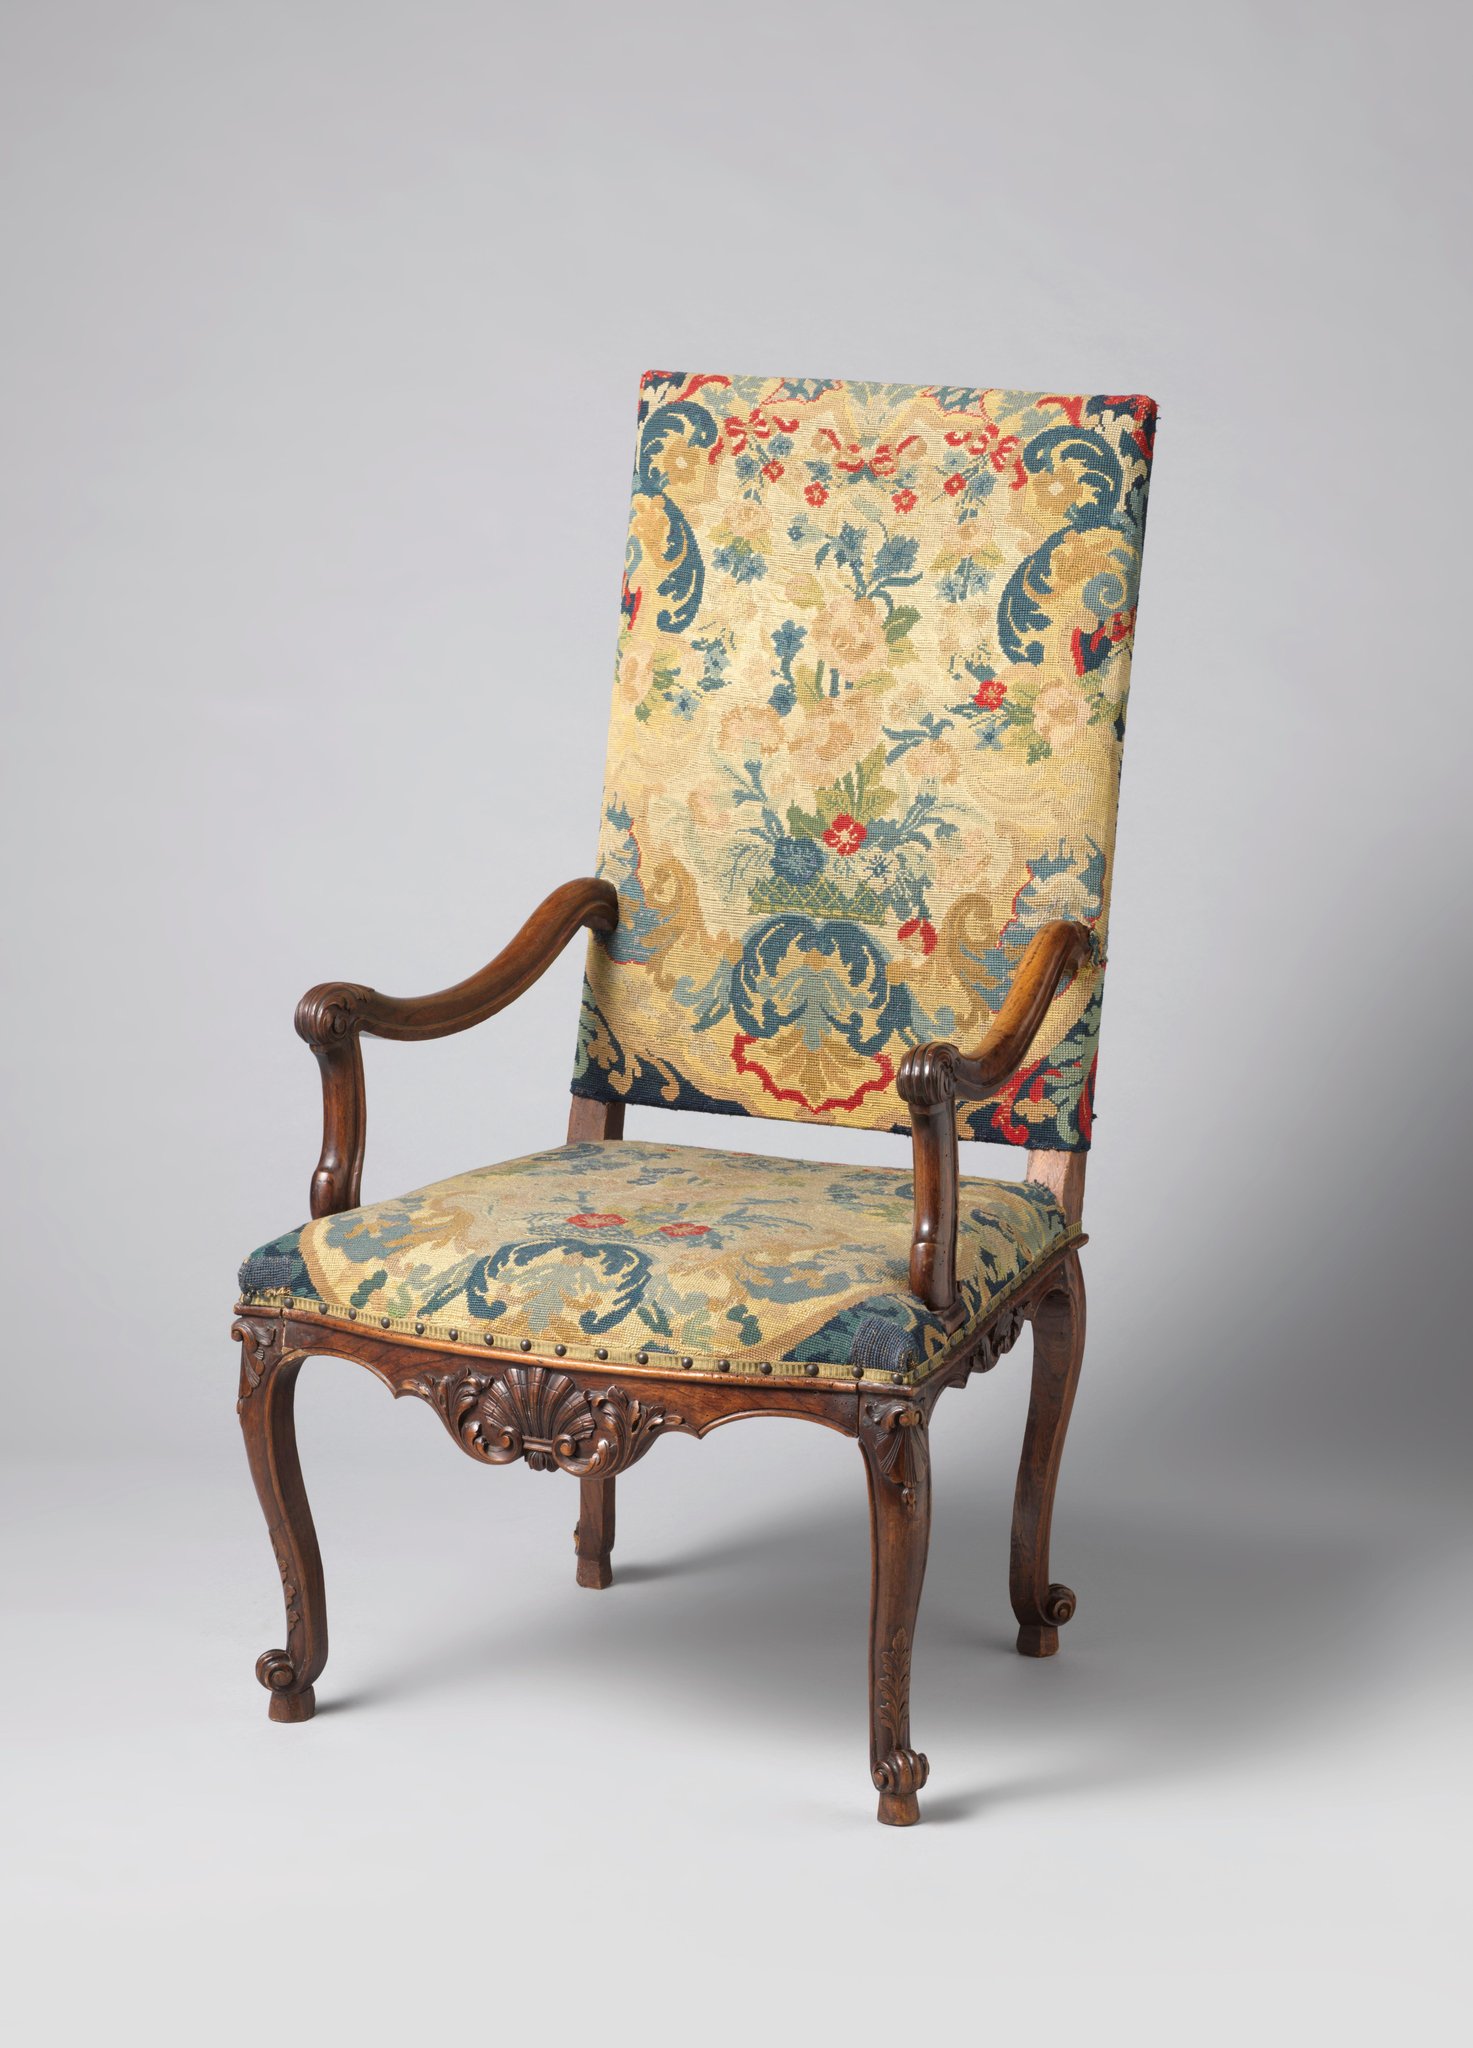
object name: armchair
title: Armstoel van notenhout met petit-point bekleding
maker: Anonymous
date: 1700-1725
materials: wood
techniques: embroidered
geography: northern netherlands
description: Side-table. Beech, gilded. Munich, c. 1730, possibly designed by Joseph Effner. Attributed to Jean-Louis Lemoyne(1665 - 1755). Elizabeth-Marie-Suzanne Le Detz. Terracotta, marble base. Paris, c. 1720. Two armchairs. Walnut, upholstered with wool and silk embroidery. Netherlands, c. 1715 - 1730. Originally from Kasteel Eerde near Ommen in the province of Overijssel. Tapestry with Diana resting from the hunt, from a set of classical gods. Wool and silk. Brussels, c. 1700 - 1750, probably designed and woven by a member of the Van der Borght family. Given by the Bank voor Handel en Scheepvaart, Rotterdam, 1955.